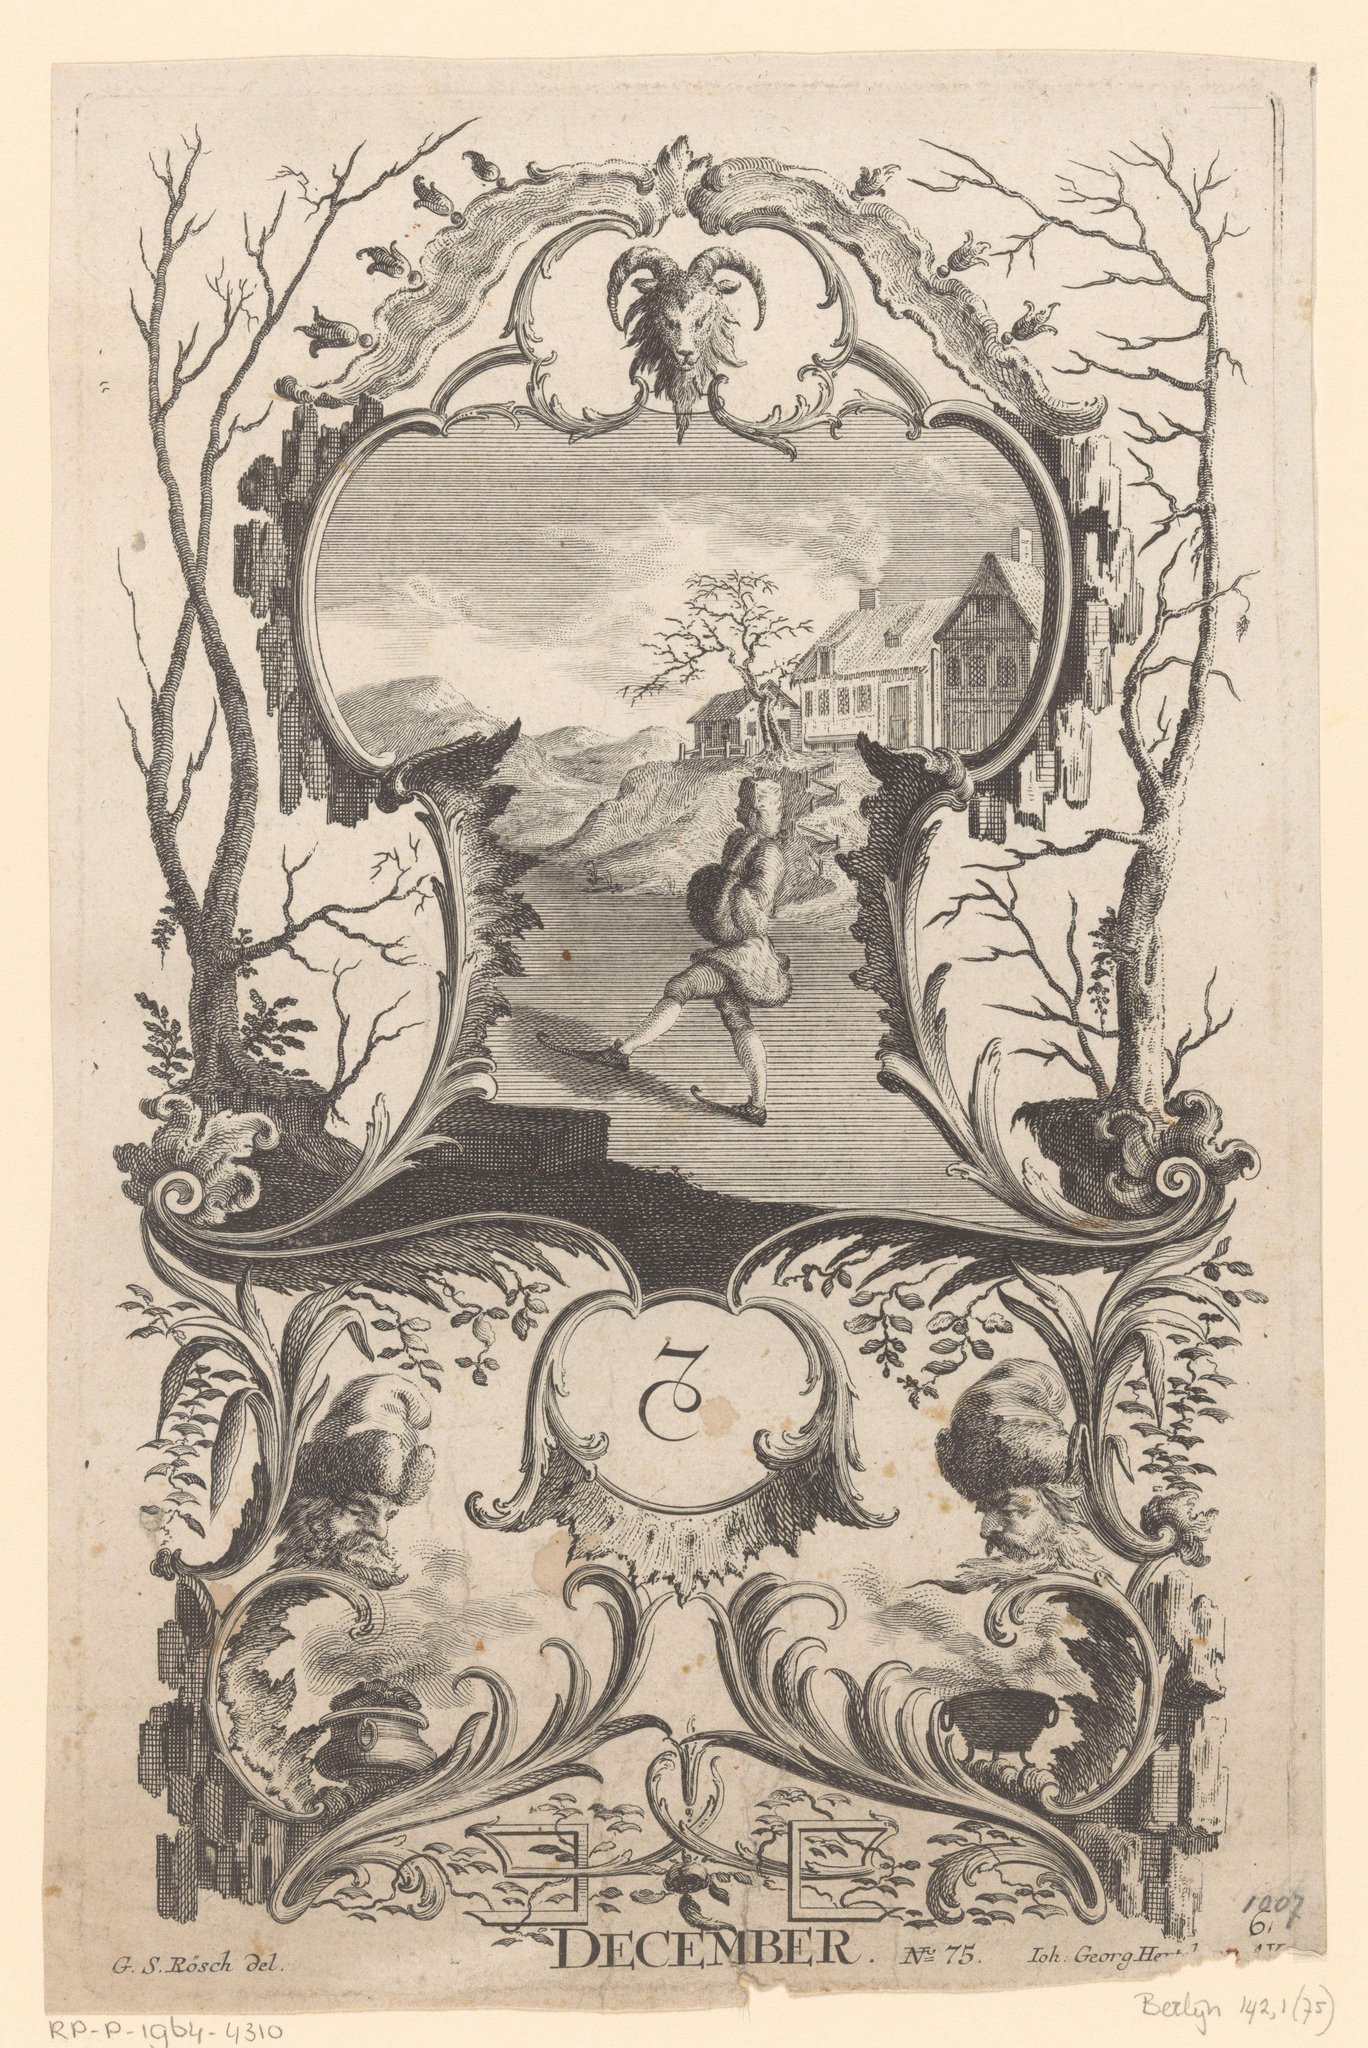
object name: ornament print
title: Laatste zes maanden van het jaar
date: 1705-1766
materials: paper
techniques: etching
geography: augsburg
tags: december and its 'labours', adult man, skates (winter sports)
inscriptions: collector's mark: Lugt 2228, collector's mark: Lugt 2760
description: In een rocaille cartouche schaatst een man met een mof op ijs. Rondom de voorstelling rocaille ornamenten, takken, twee mannengezichten met baard en muts, een ramskop en het bijbehorende teken van de dierenriem. Uitgeversnummer 75..